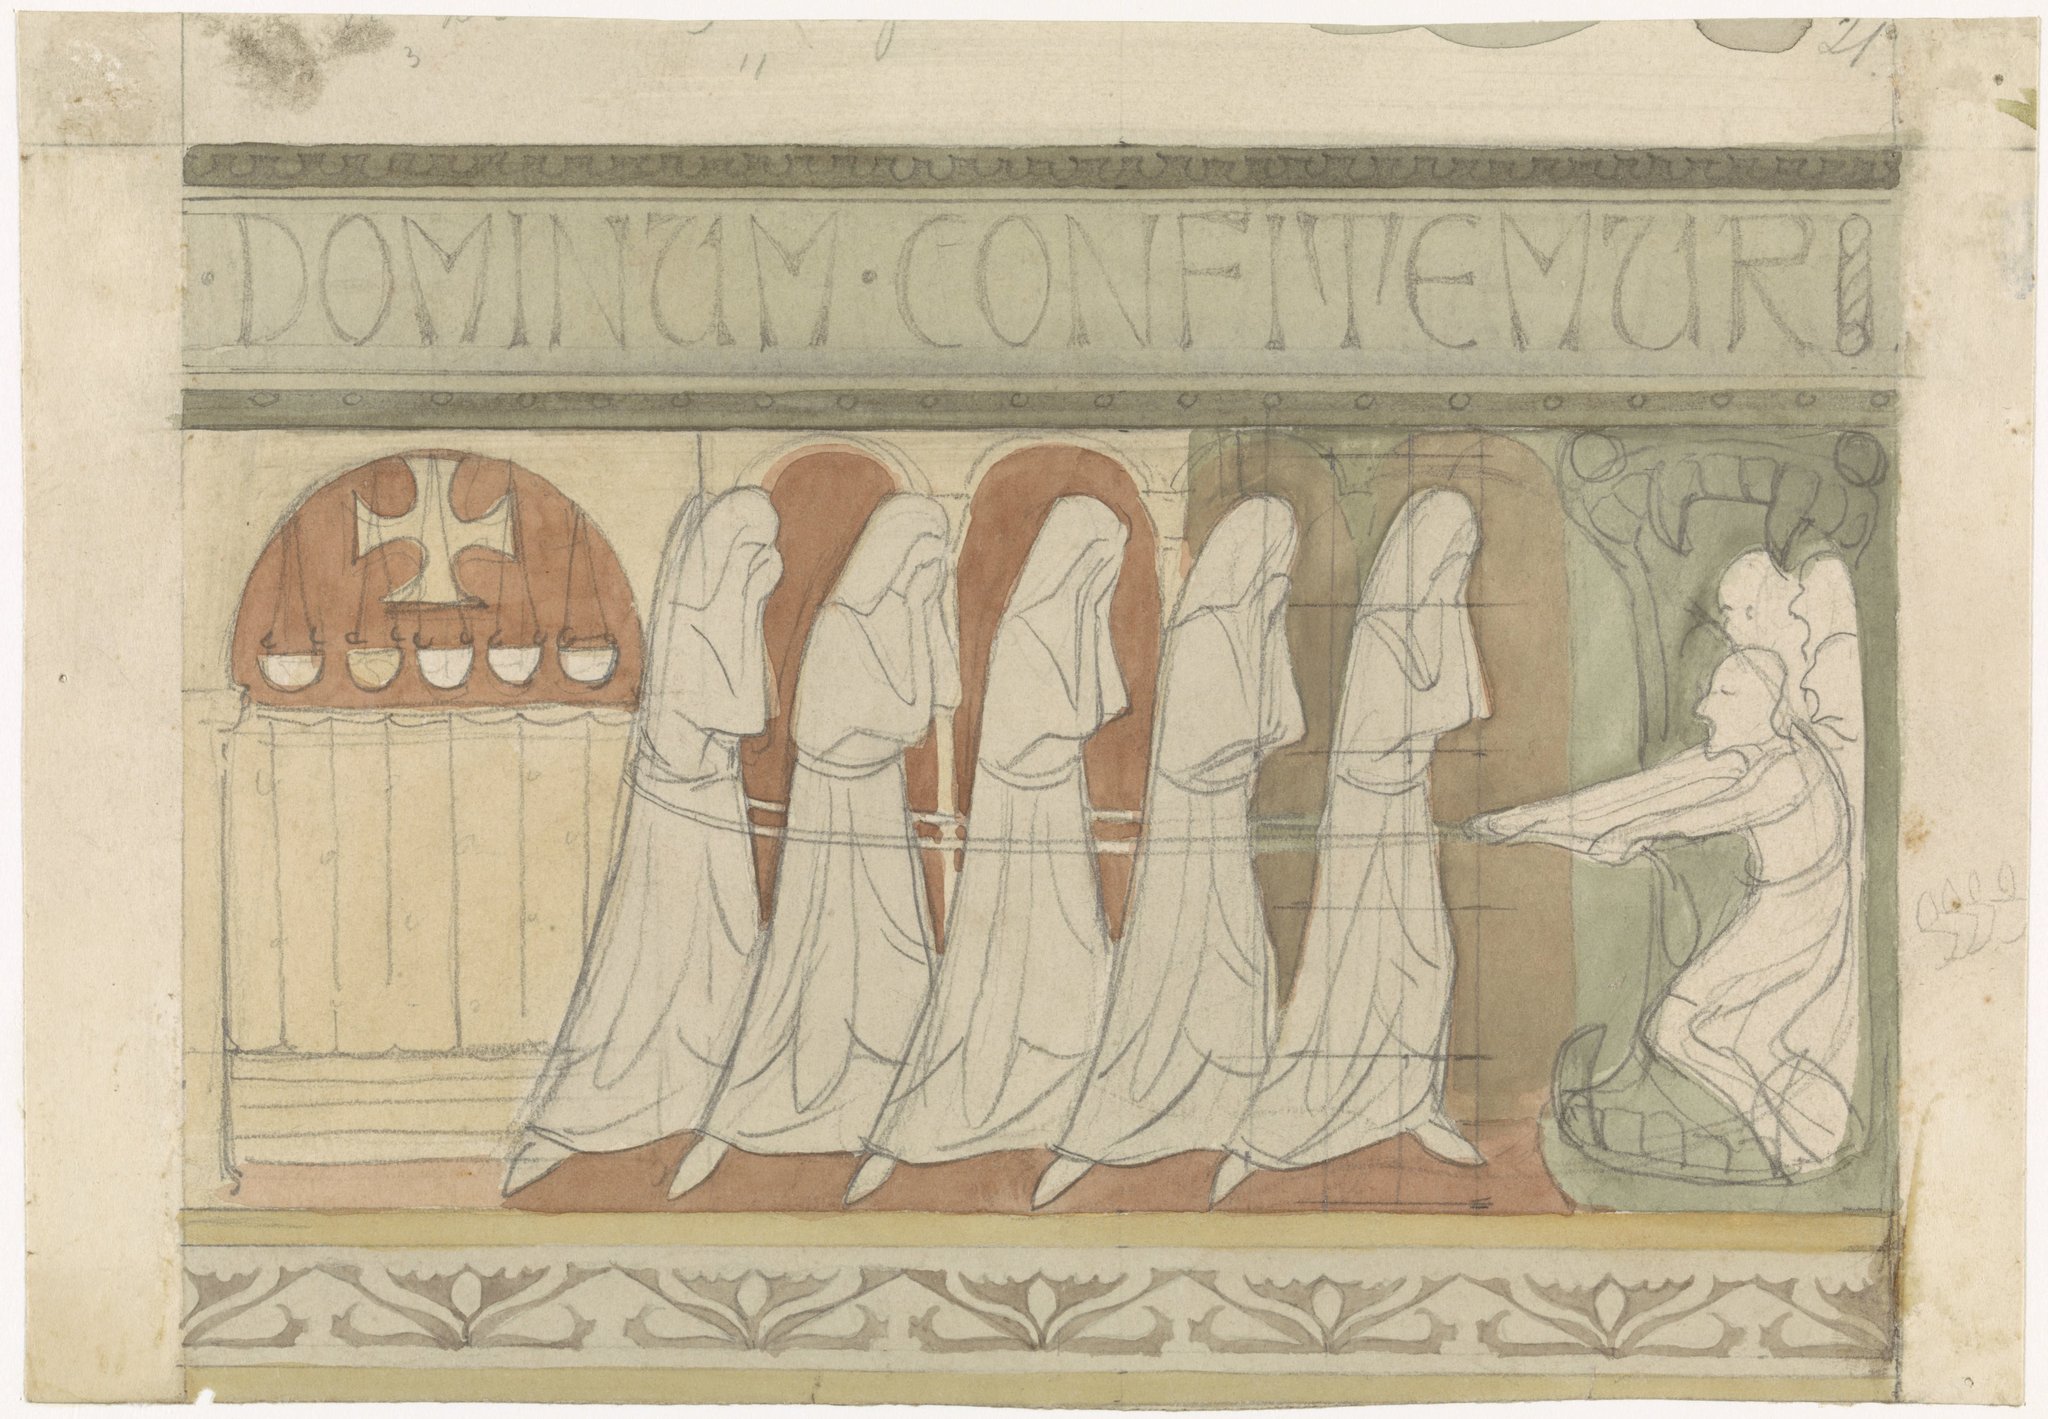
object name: watercolor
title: De vijf dwaze maagden worden door de duivel de hel ingetrokken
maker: antoon derkinderen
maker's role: draughtsman, painter, print maker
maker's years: 1859-1925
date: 1869-1925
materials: paper, pencil, watercolor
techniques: brush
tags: the wise virgins are let into the house with the bridegroom (christ); the foolish virgins are shut out (+ variant)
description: De tekening betreft het ontwerp voor een wandschildering.